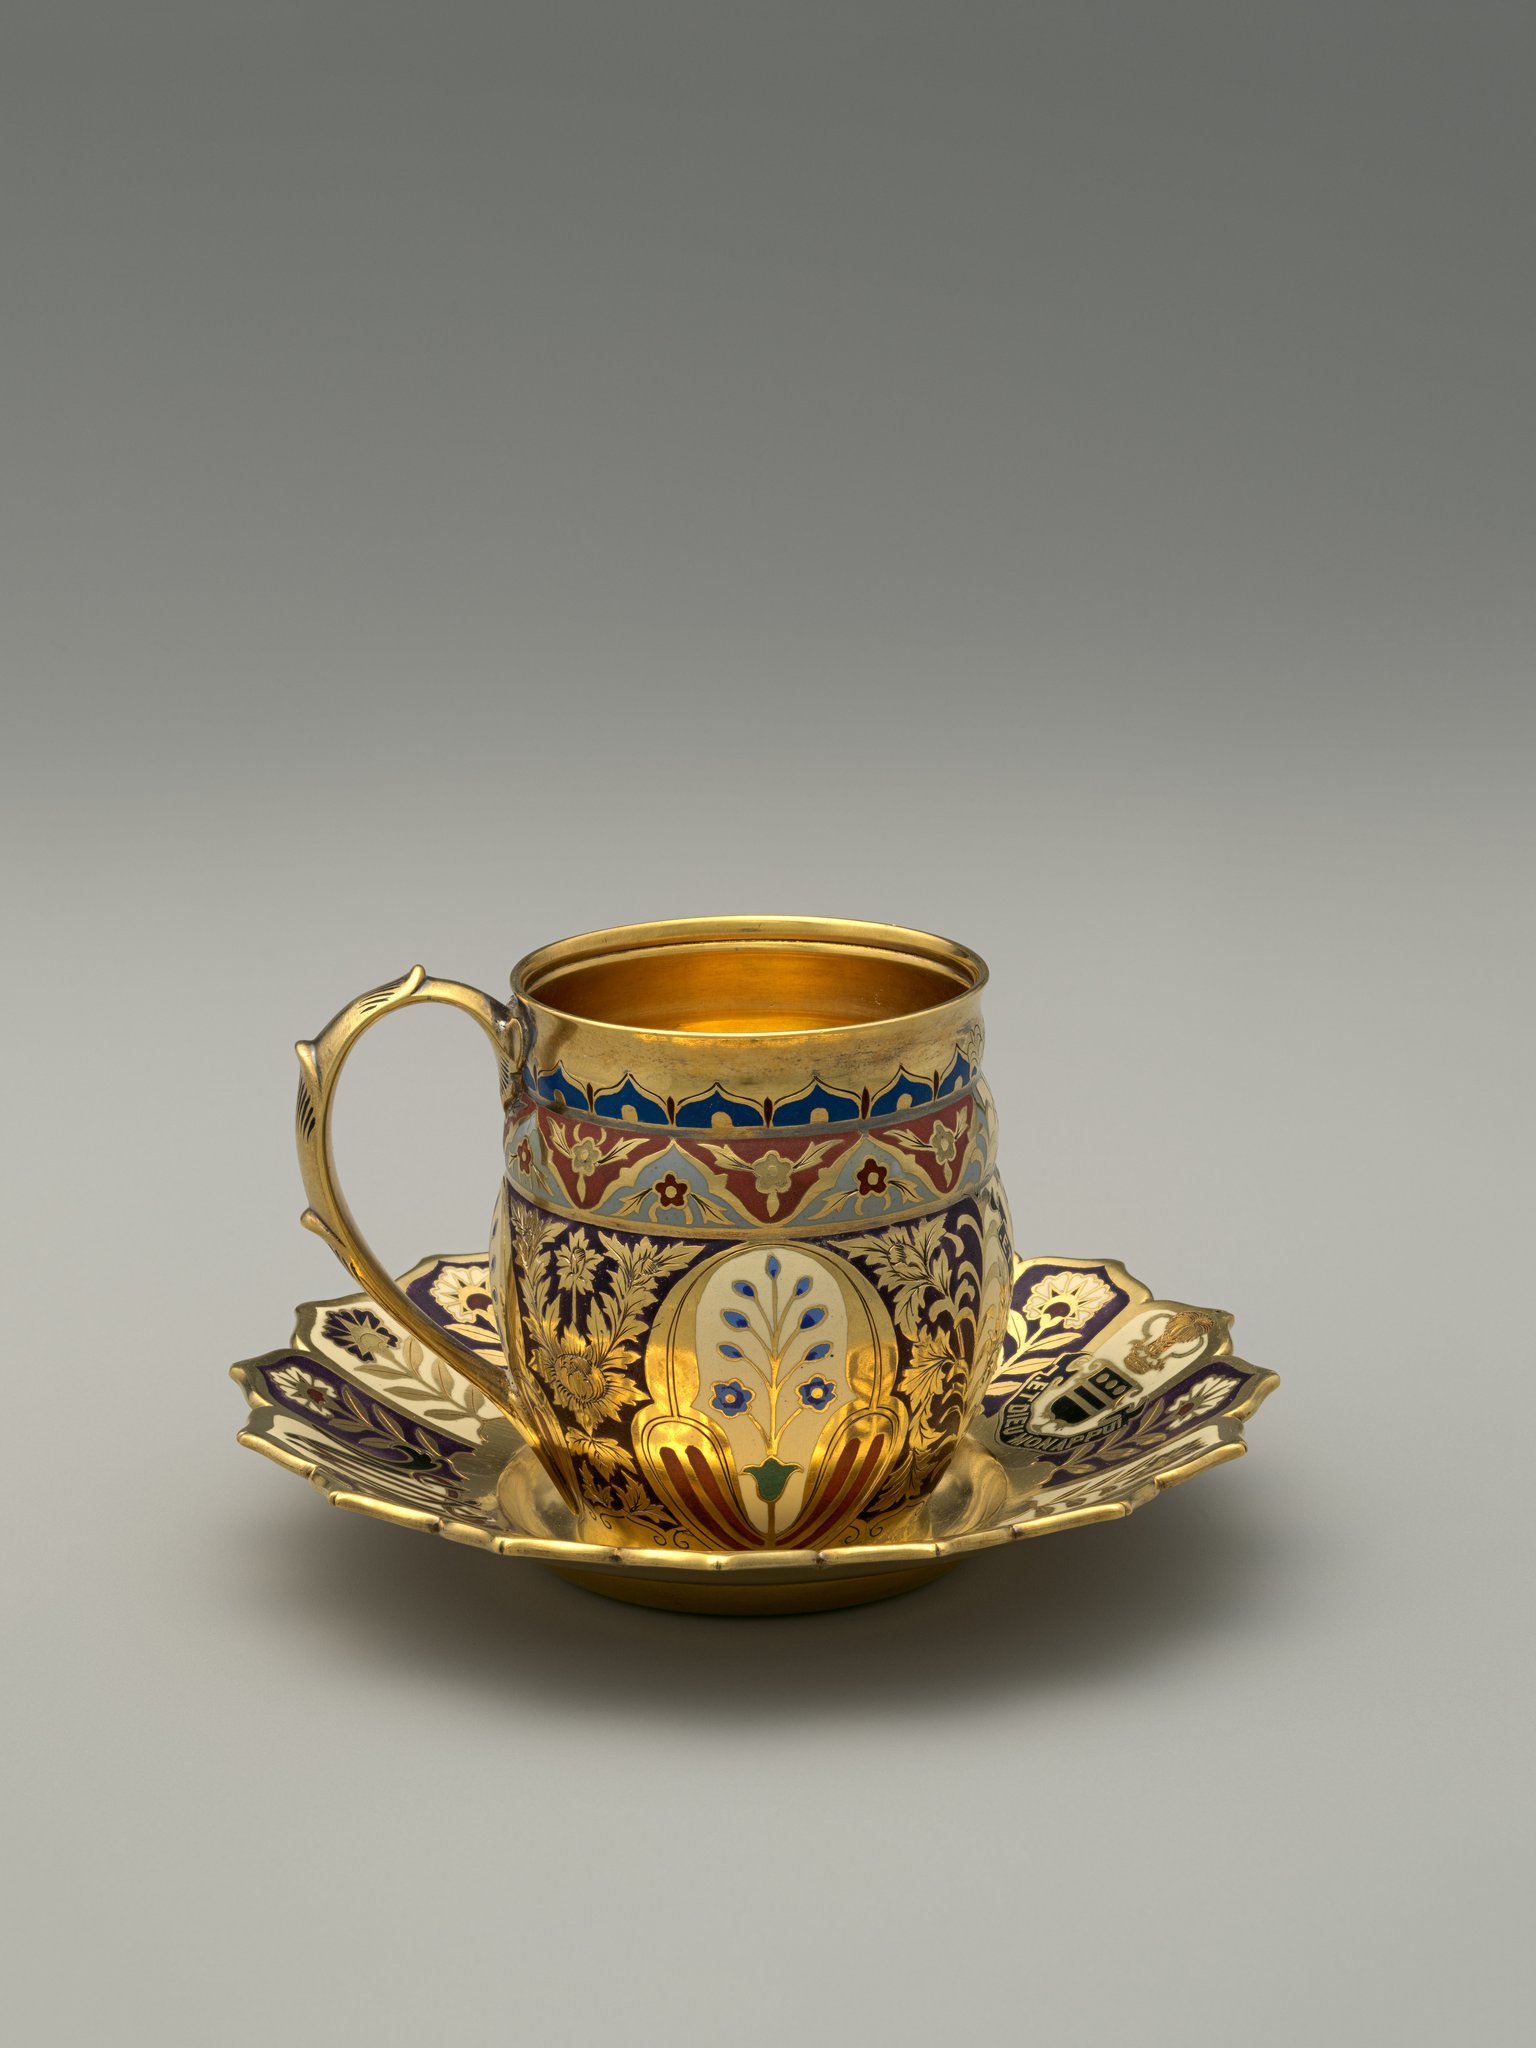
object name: cup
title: Cup from the Mackay Service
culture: american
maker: tiffany & co.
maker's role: maker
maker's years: 1837-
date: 1878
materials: enamel, silver gilt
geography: united states